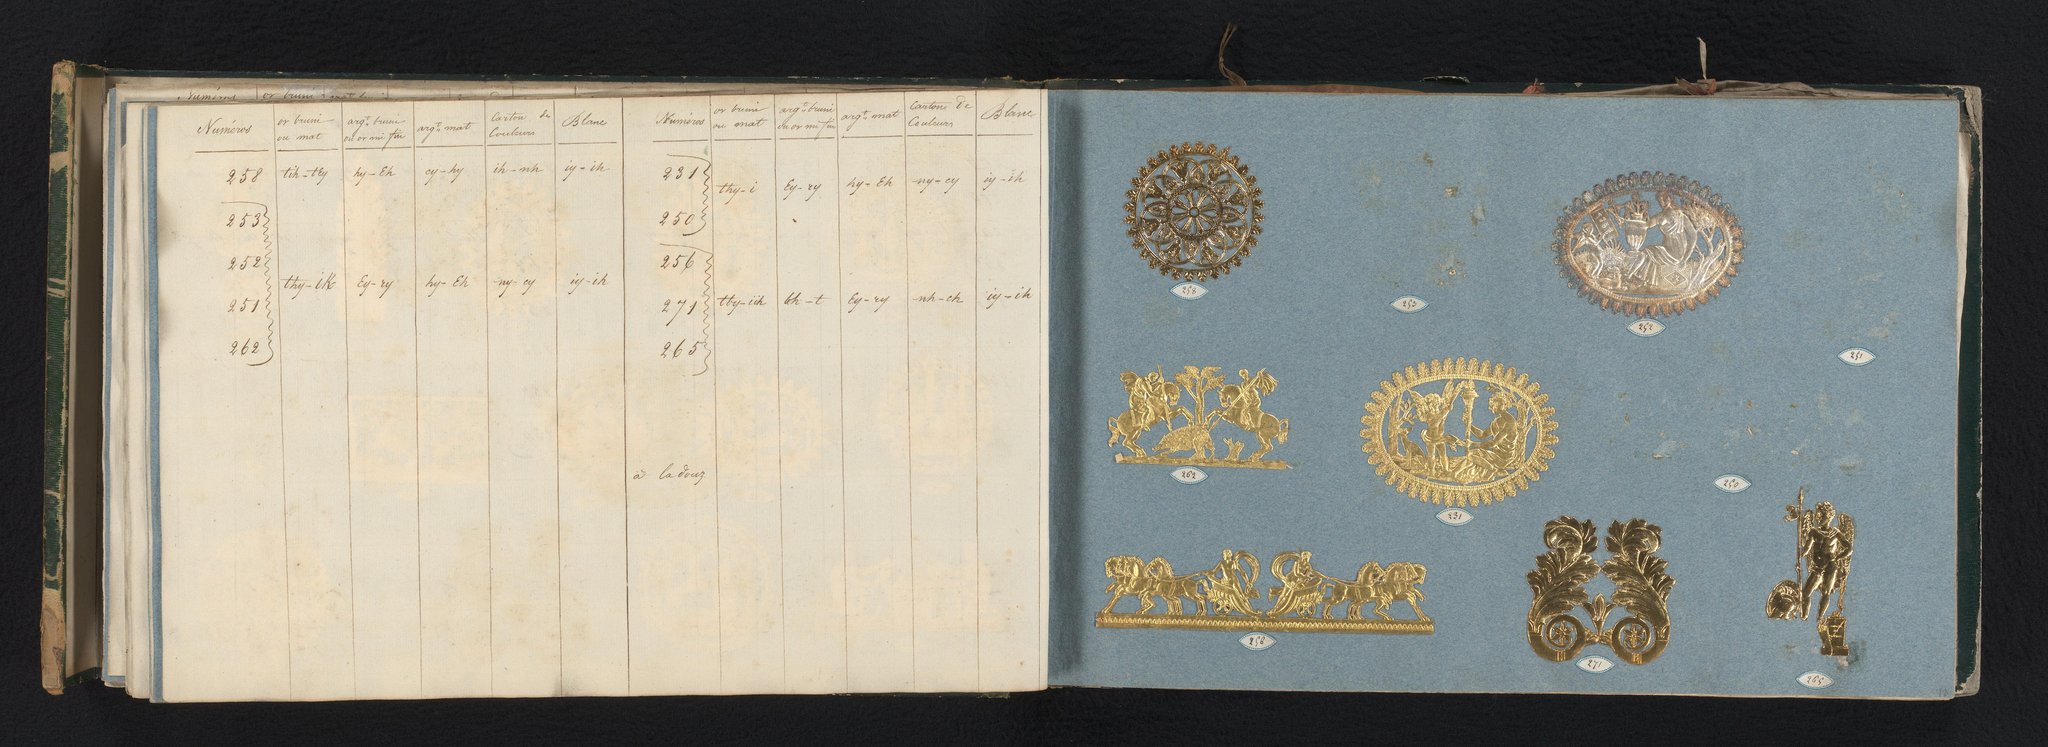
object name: metallic paper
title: Twee bladzijden met stalen van vignetten van goud- en zilverkleurig metaalpapier en bijbehorend tabel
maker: Anonymous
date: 1830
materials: gold leaf, ink, paper, silver leaf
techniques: manufacturing, writing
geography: france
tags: ornaments ~ art, boar-hunting, chariot, triumphal car, specific aspects, allegorical aspects of venus; venus as patroness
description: Twee bladzijden met rechts 7 opgeplakte en met etiketten genummerde (258-265) stalen van afzonderlijke vignetten en emblemen van goud- en zilverkleurig metaalpapier (stalen nrs. 253, 251 en 250 ontbreken). Voorstellingen van o.a. zwijnenjacht, Venus en Amor en strijdwagens. Op de tegenoverliggende linkerbladzijde een tabel met de handgeschreven corresponderende specificaties (in code) per ornament. Onderdeel van het stalenboek geschonken door de dames Van Rijn, vermoedelijk van een Franse papierfabrikant van luxe papieren, of diens vertegenwoordiger in Nederland, ca. 1830.